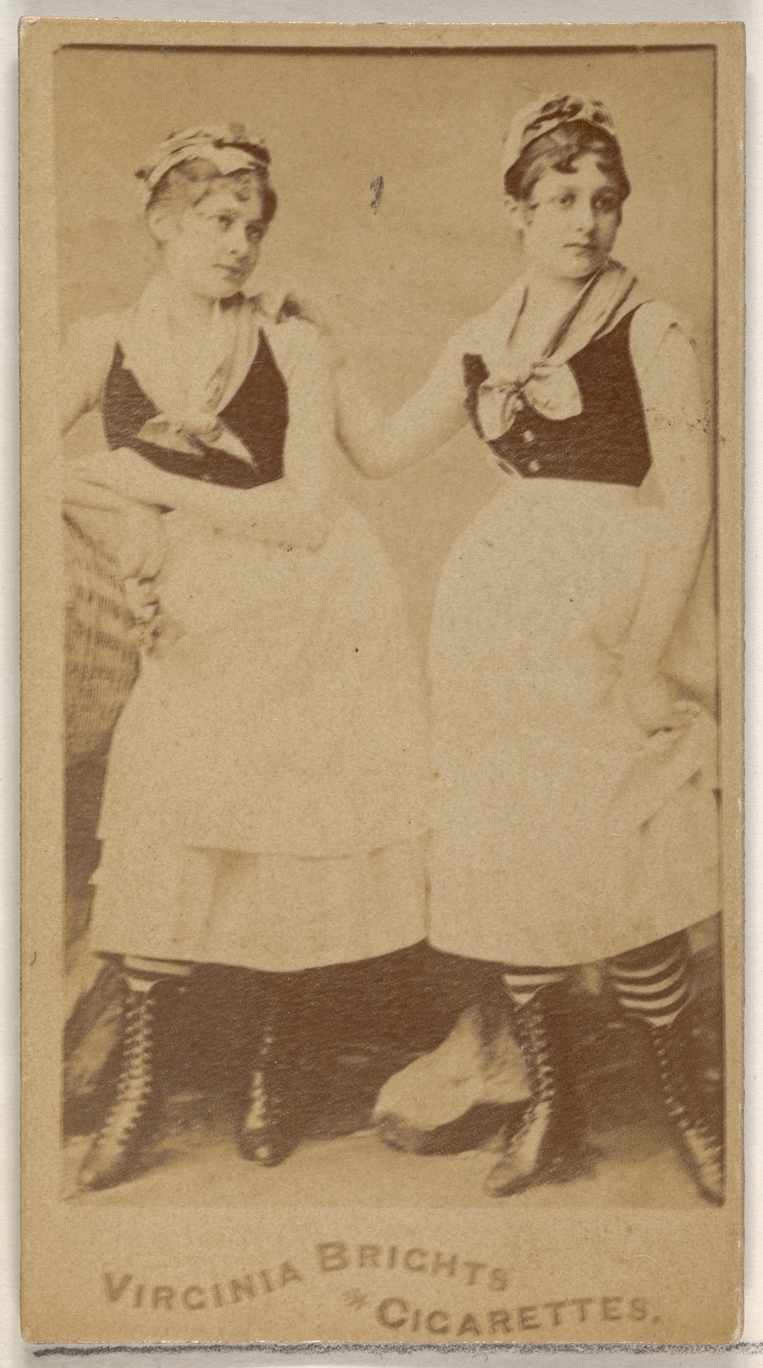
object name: photograph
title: From the Actors and Actresses series (N45, Type 5) for Virginia Brights Cigarettes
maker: allen & ginter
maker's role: publisher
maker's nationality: american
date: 1888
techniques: albumen silver print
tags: portraits,women,actresses